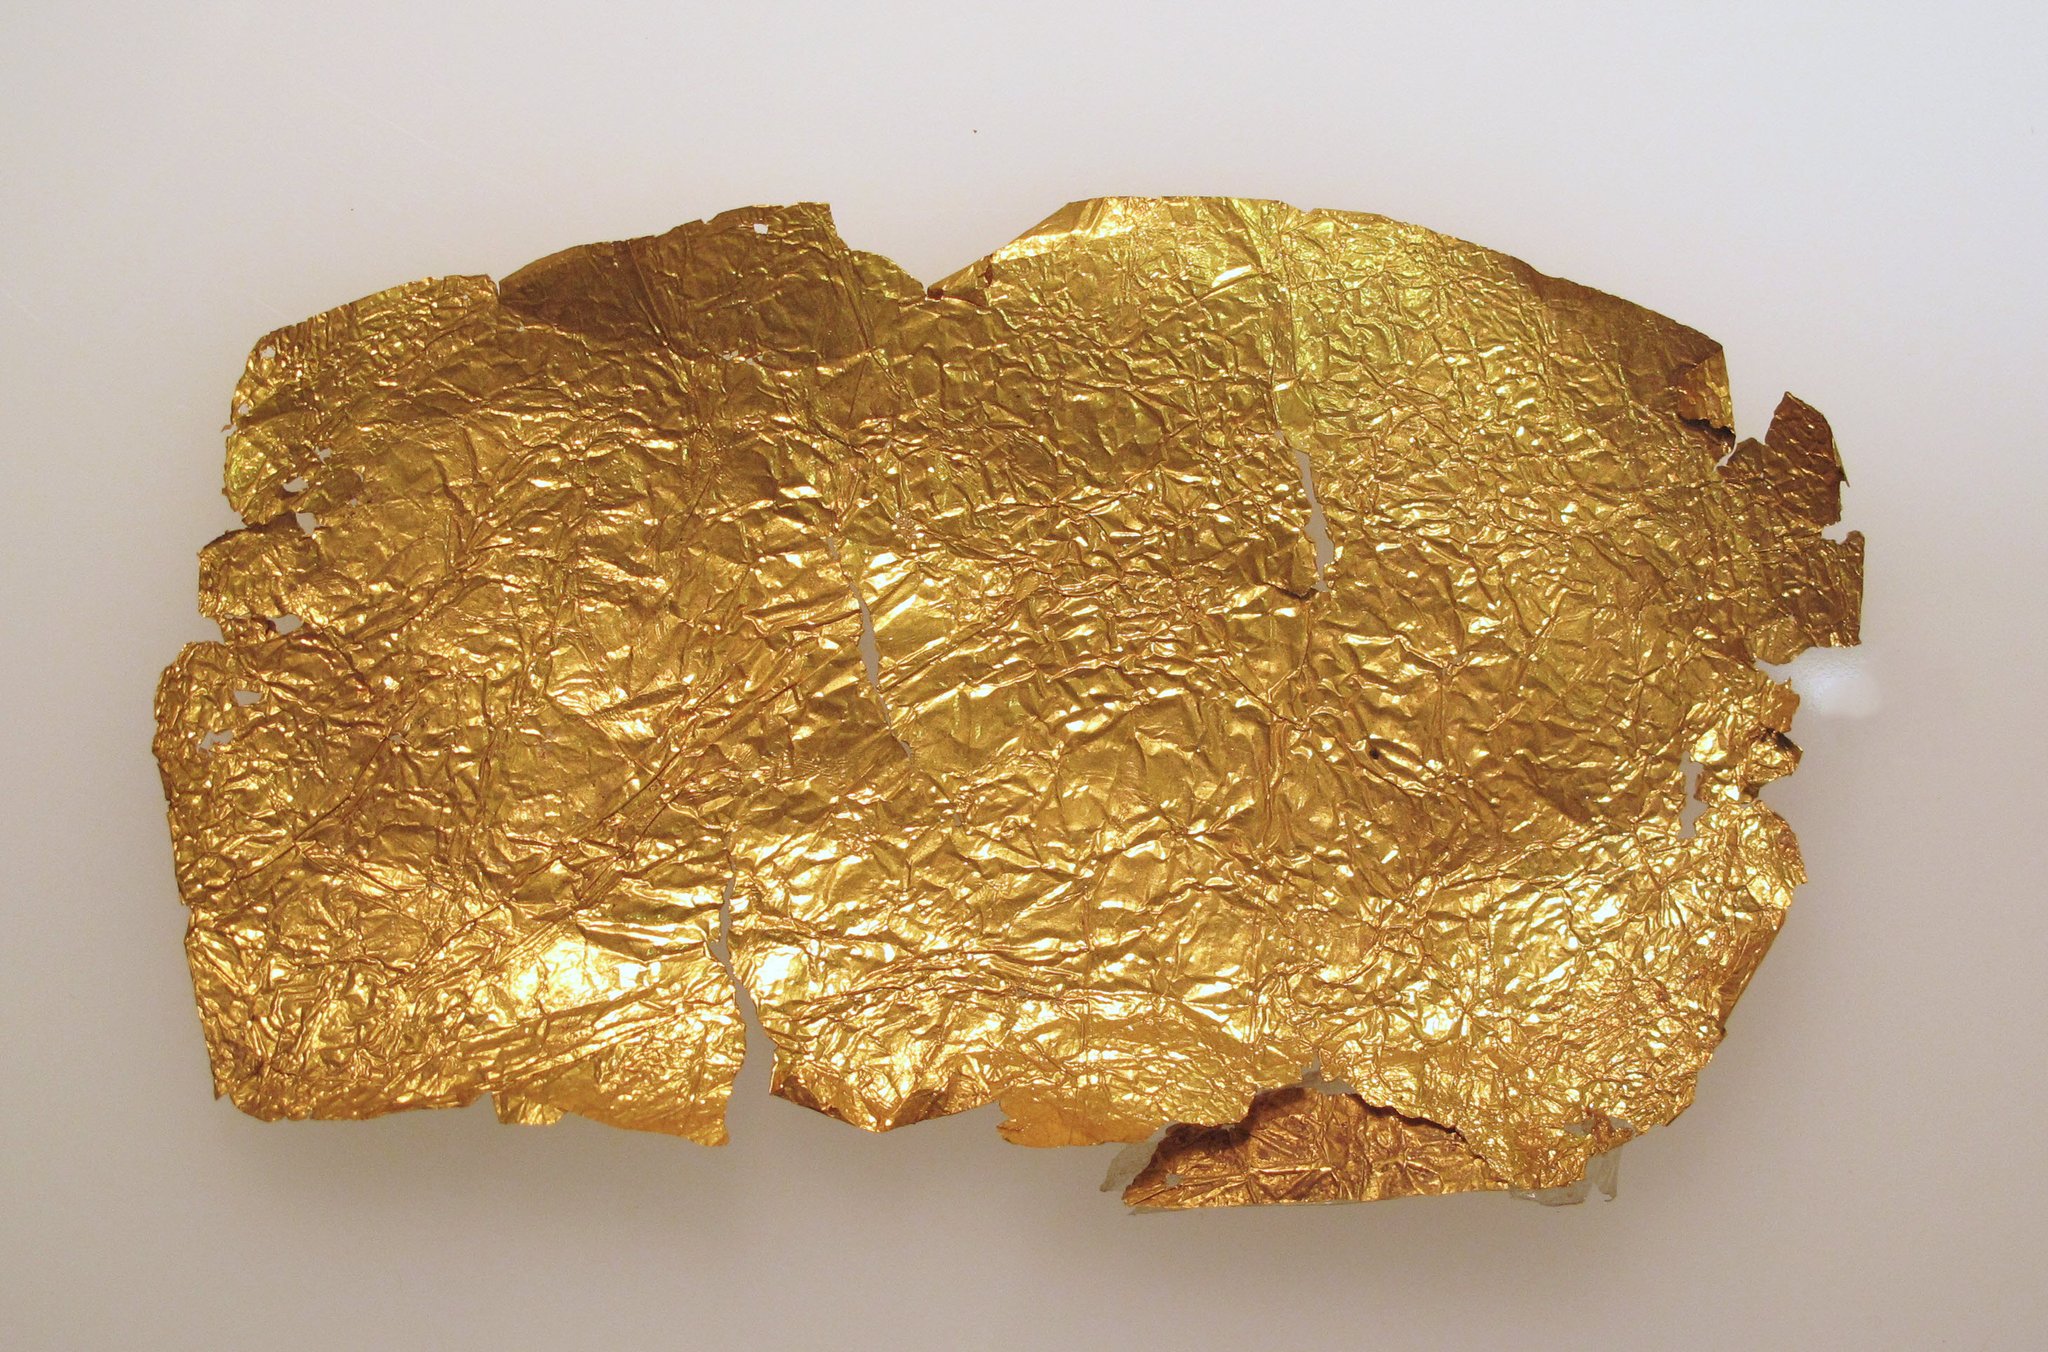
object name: frontlet of gold leaf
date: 7000 BCE-330 CE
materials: gold